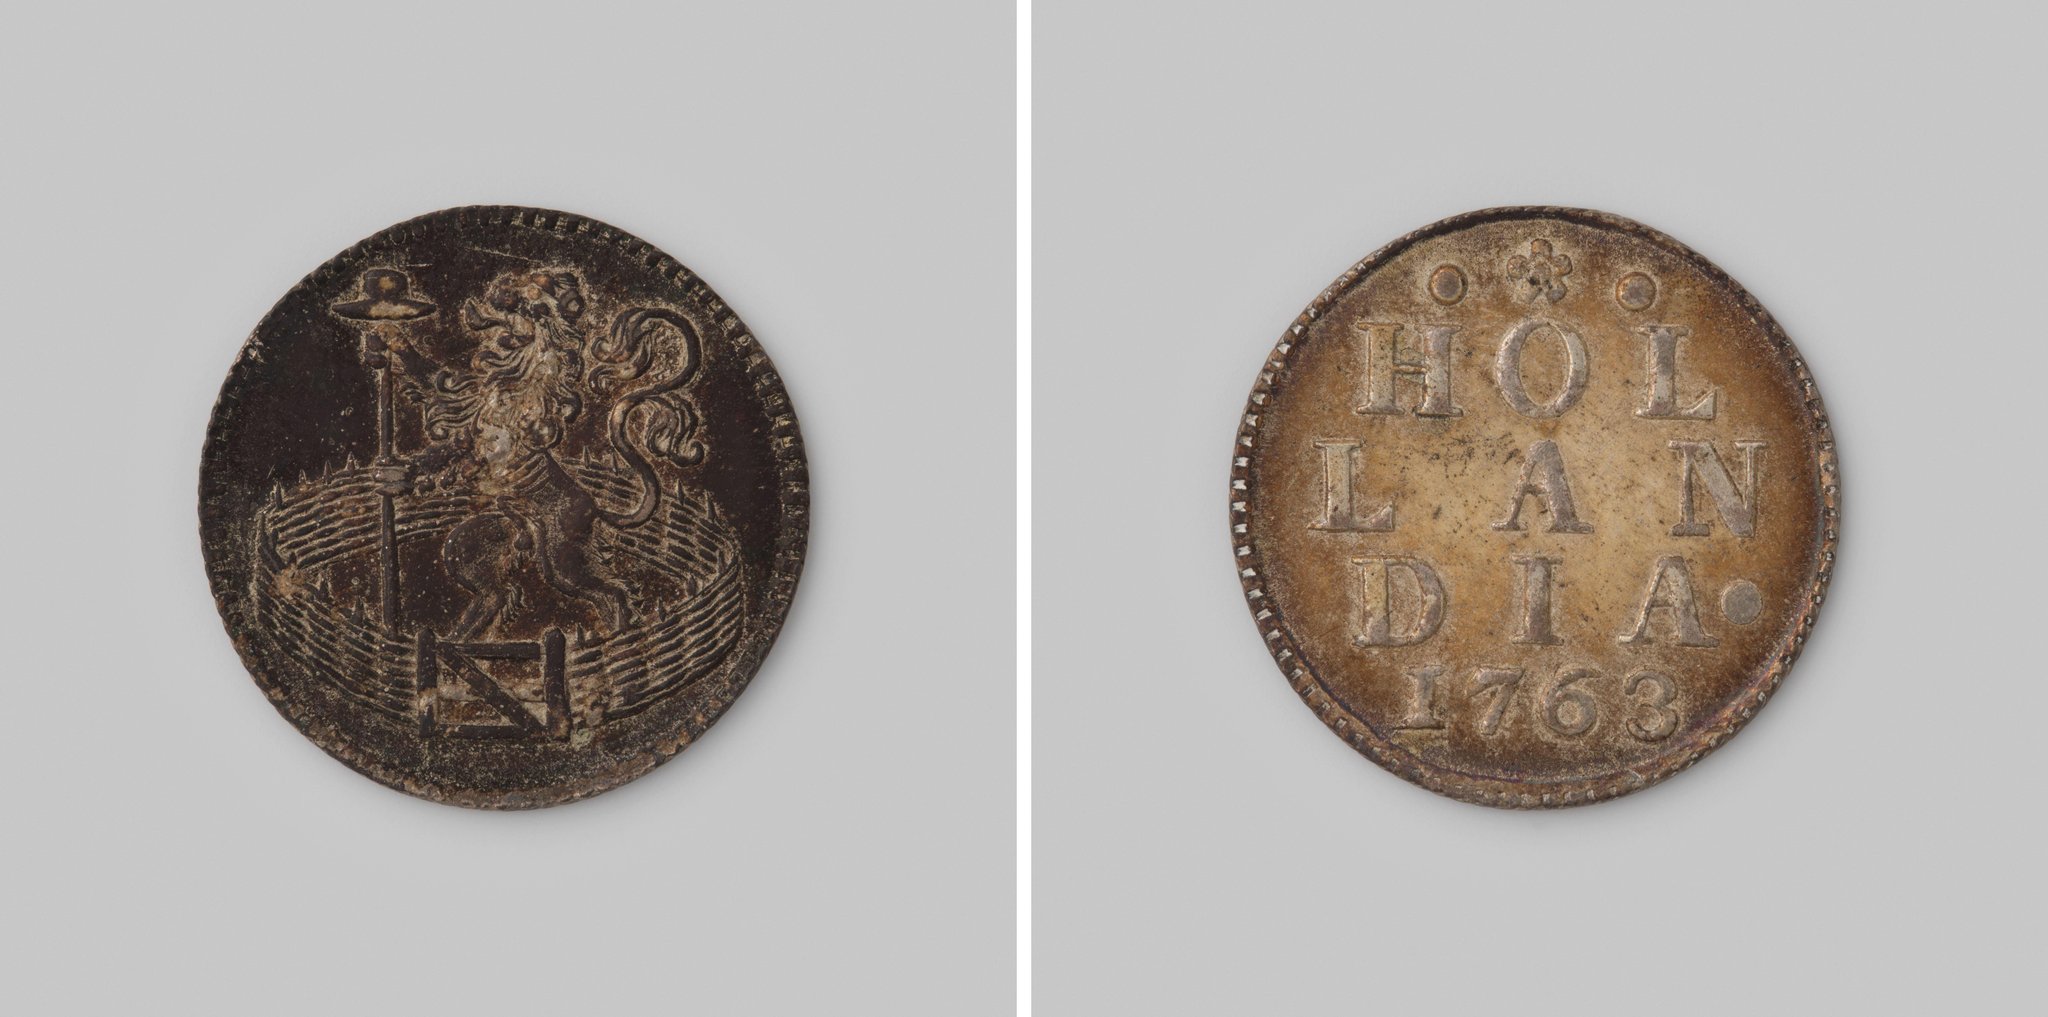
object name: coin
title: Holland, duit, 1763. Afslag in zilver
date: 1763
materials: silver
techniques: striking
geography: dordrecht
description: Zilveren munt. Voorzijde: binnen omheining staande leeuw met vrijheidshoed op speer. Keerzijde: opschrift: provincienaam in drie regels, daaronder jaartal. Kabelrand.